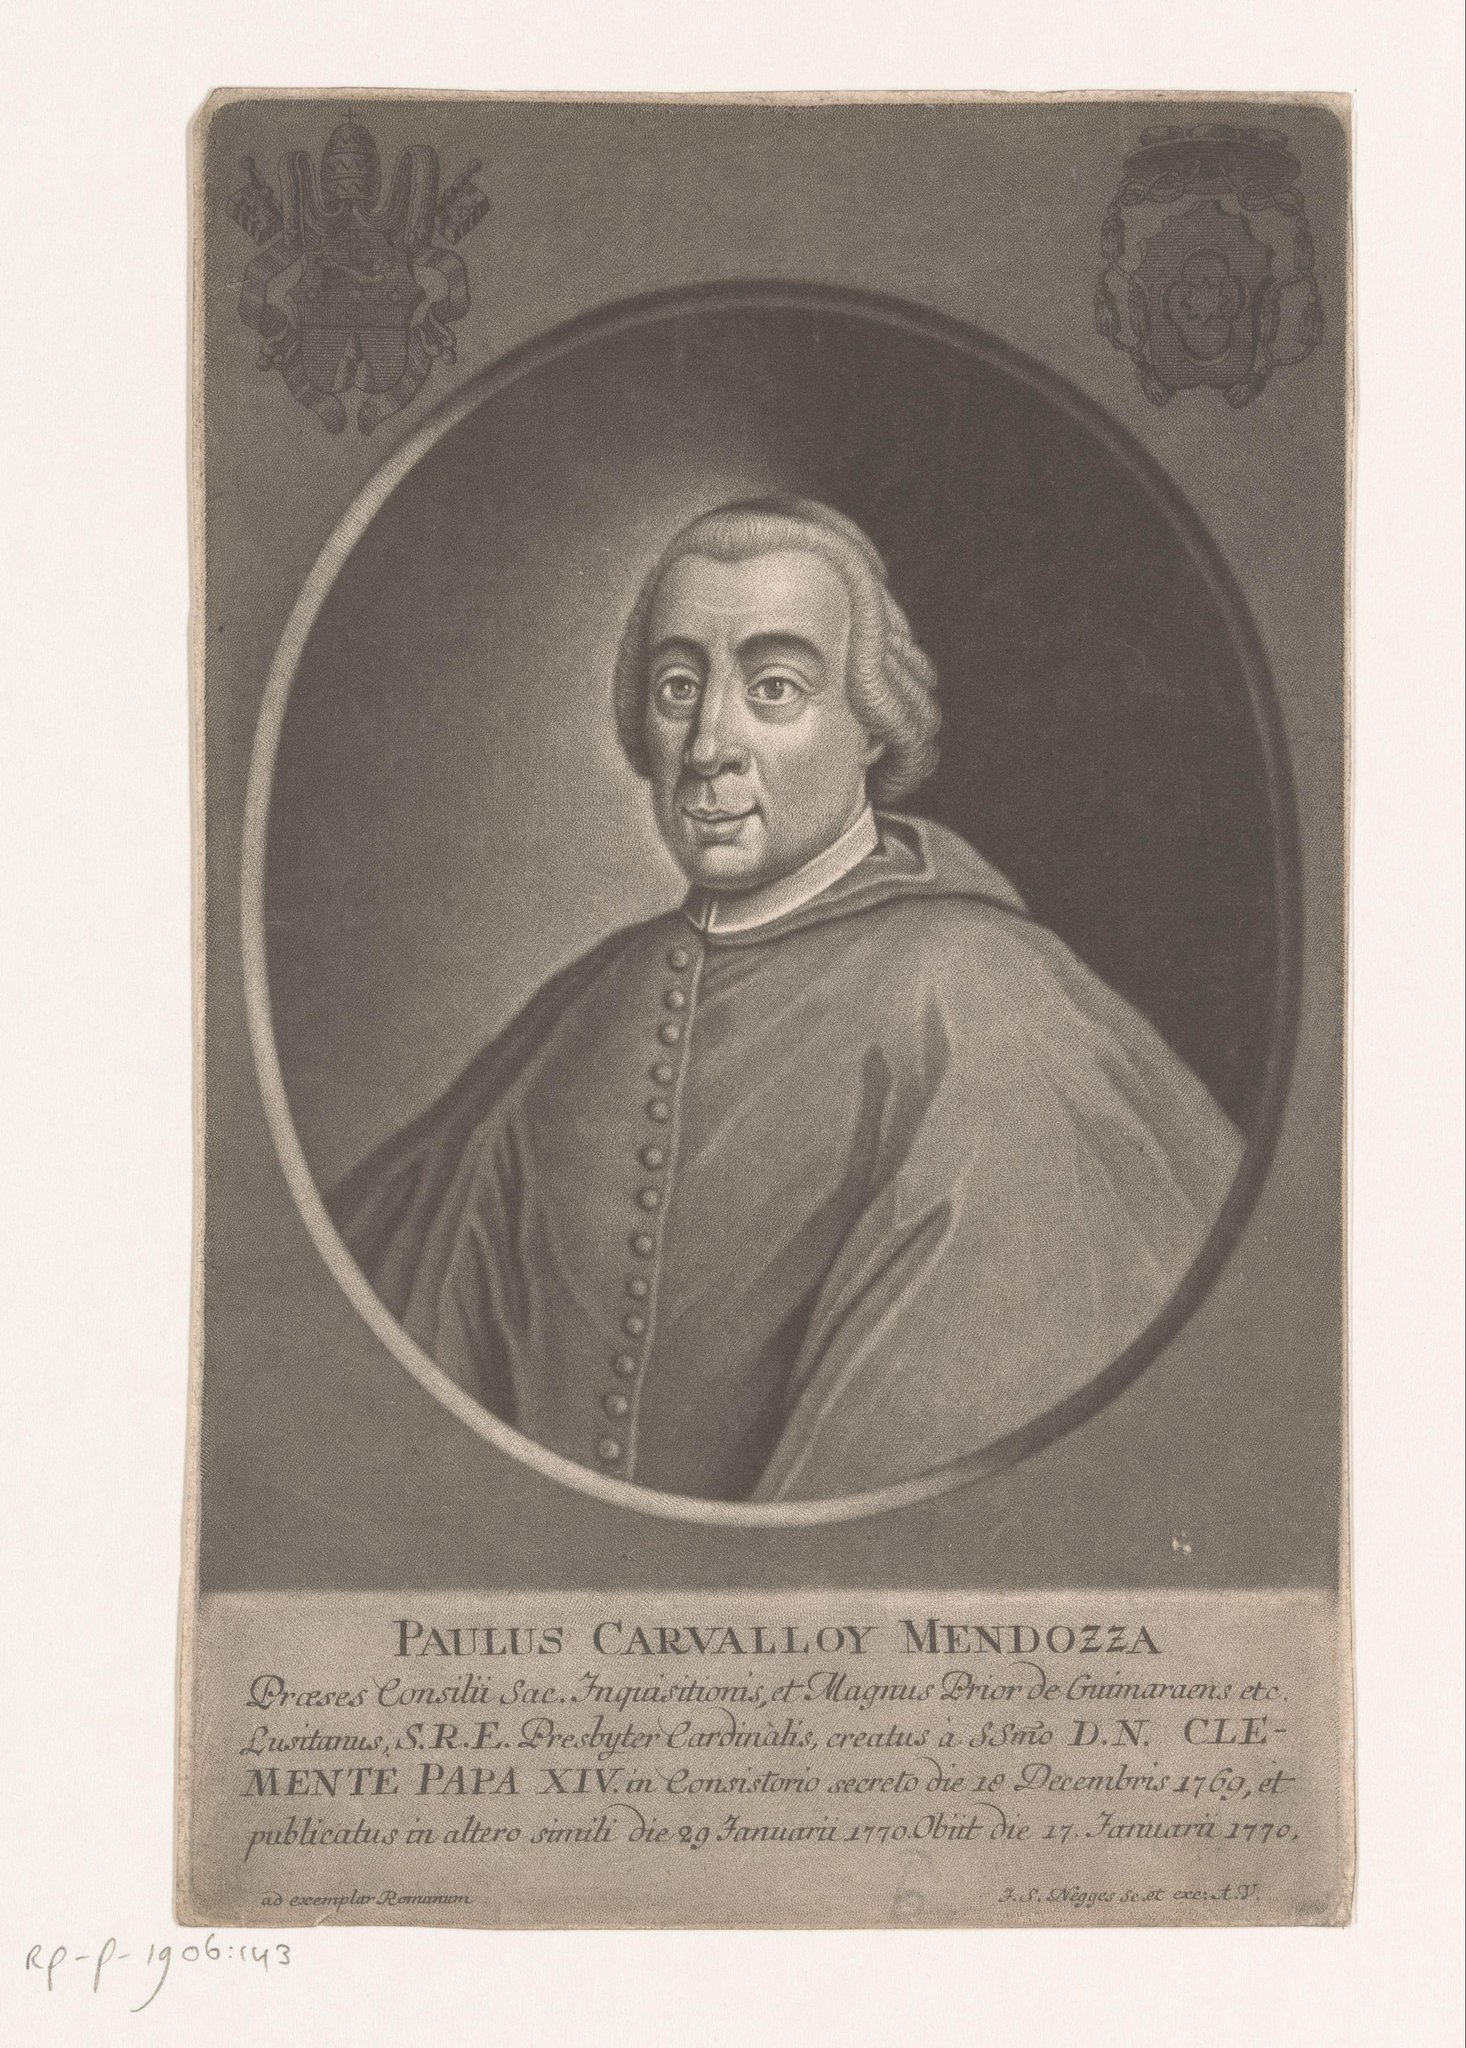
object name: print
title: Portret van Paulo António de Carvalho e Mendonça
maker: johann simon negges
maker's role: print maker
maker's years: 1726-1792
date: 1736-1792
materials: paper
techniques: mezzotint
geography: augsburg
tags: priest, historical persons, armorial bearing, heraldry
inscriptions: collector's mark: Lugt 2228